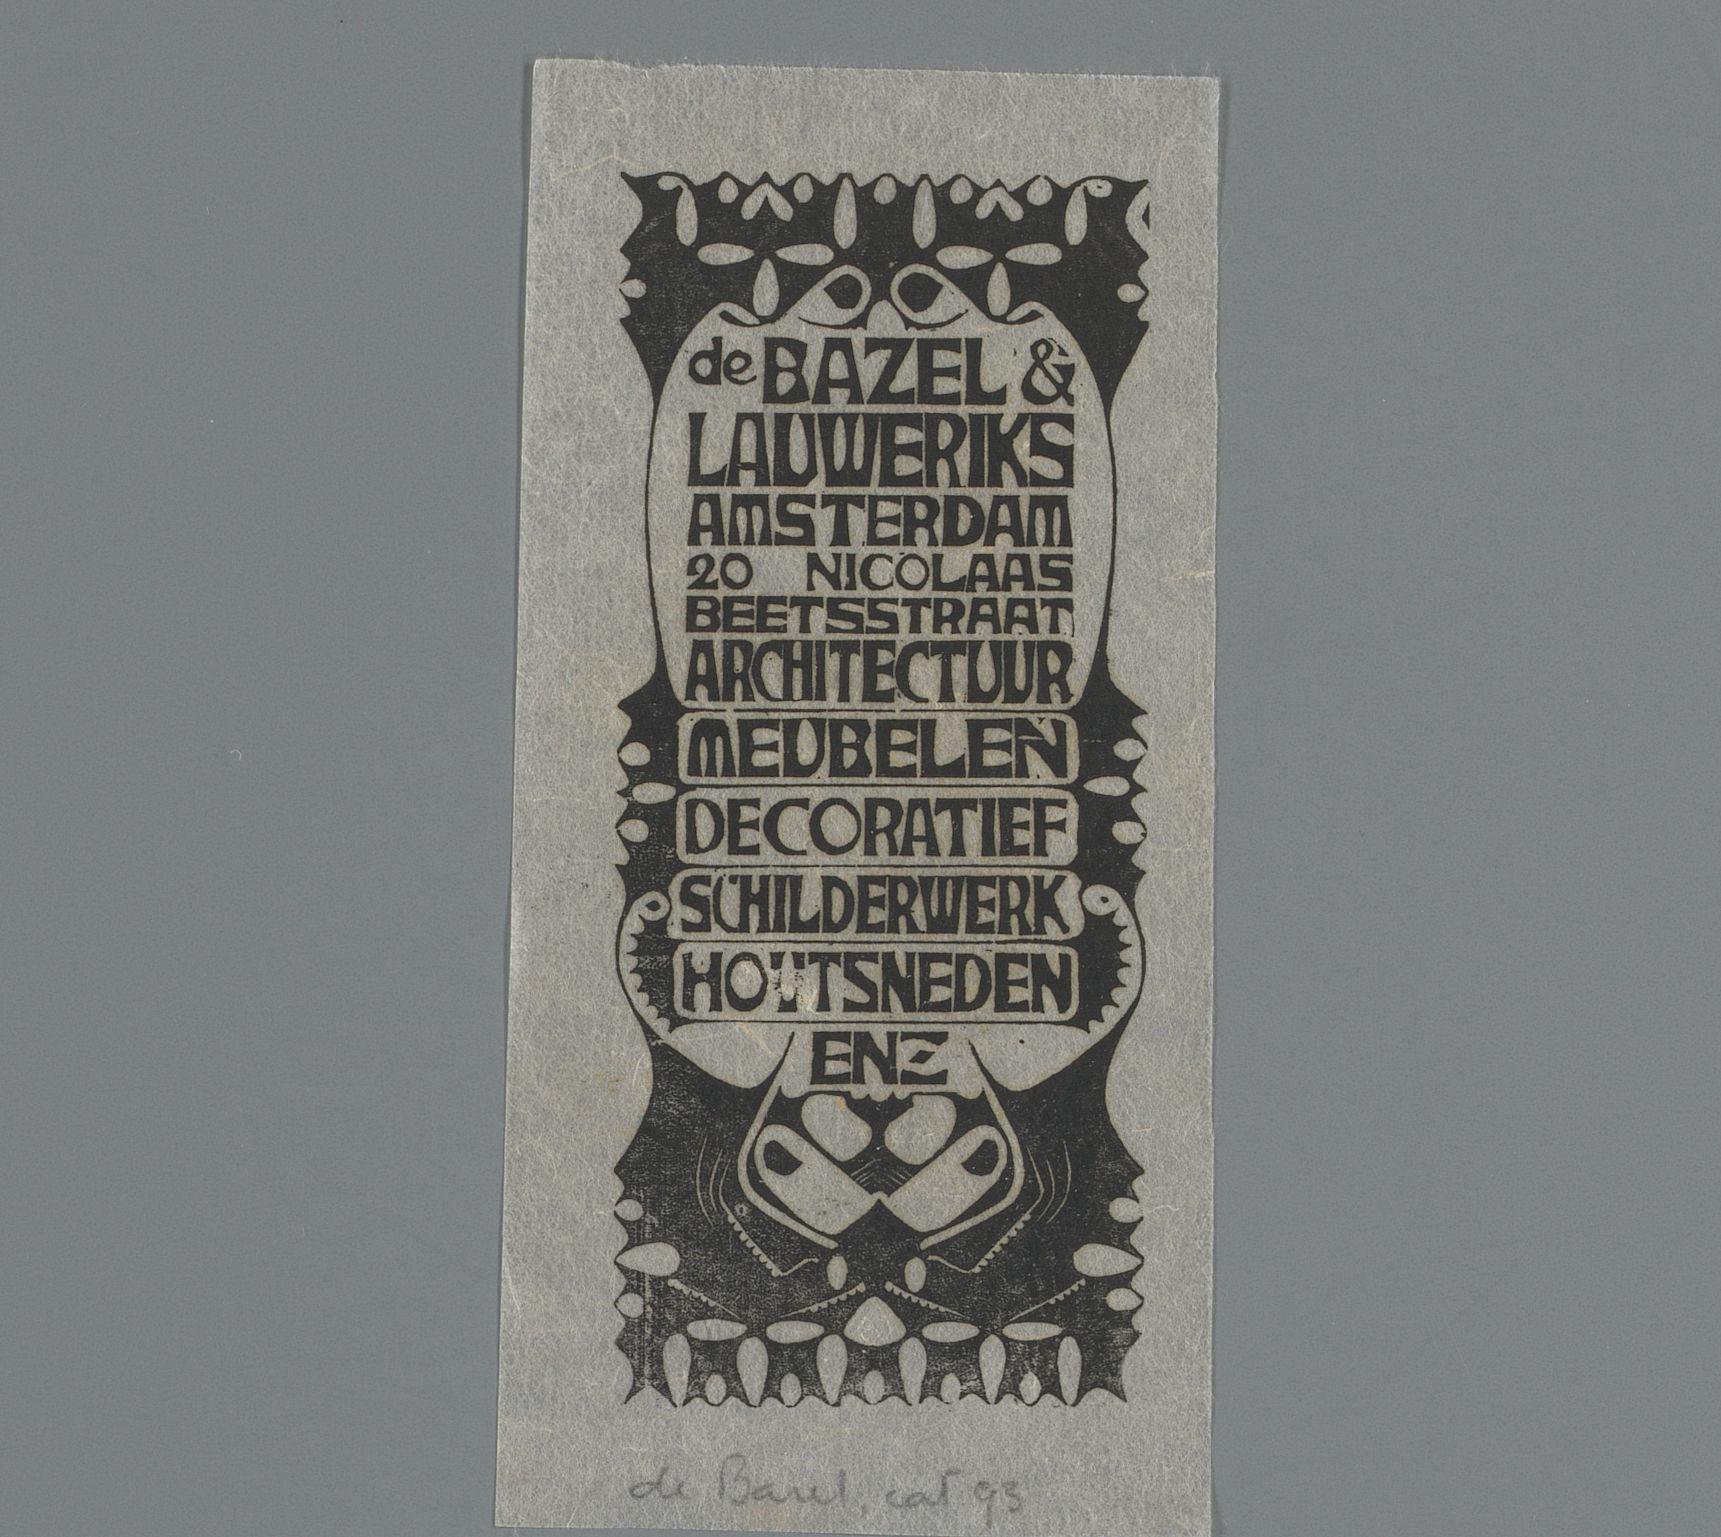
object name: print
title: Visitekaart voor het atelier van Karel de Bazel en Mathieu Lauweriks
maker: karel petrus cornelis de bazel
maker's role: draughtsman, print maker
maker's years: 1869-1923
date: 1898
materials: paper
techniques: woodcut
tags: karel petrus cornelis de bazel, amsterdam, print maker, draughtsman, designer, mathieu lauweriks, ornaments ~ art, visiting-card, calling-card, fancy letters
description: Visitekaart met een decoratief kader rond de adrestekst van het atelier.